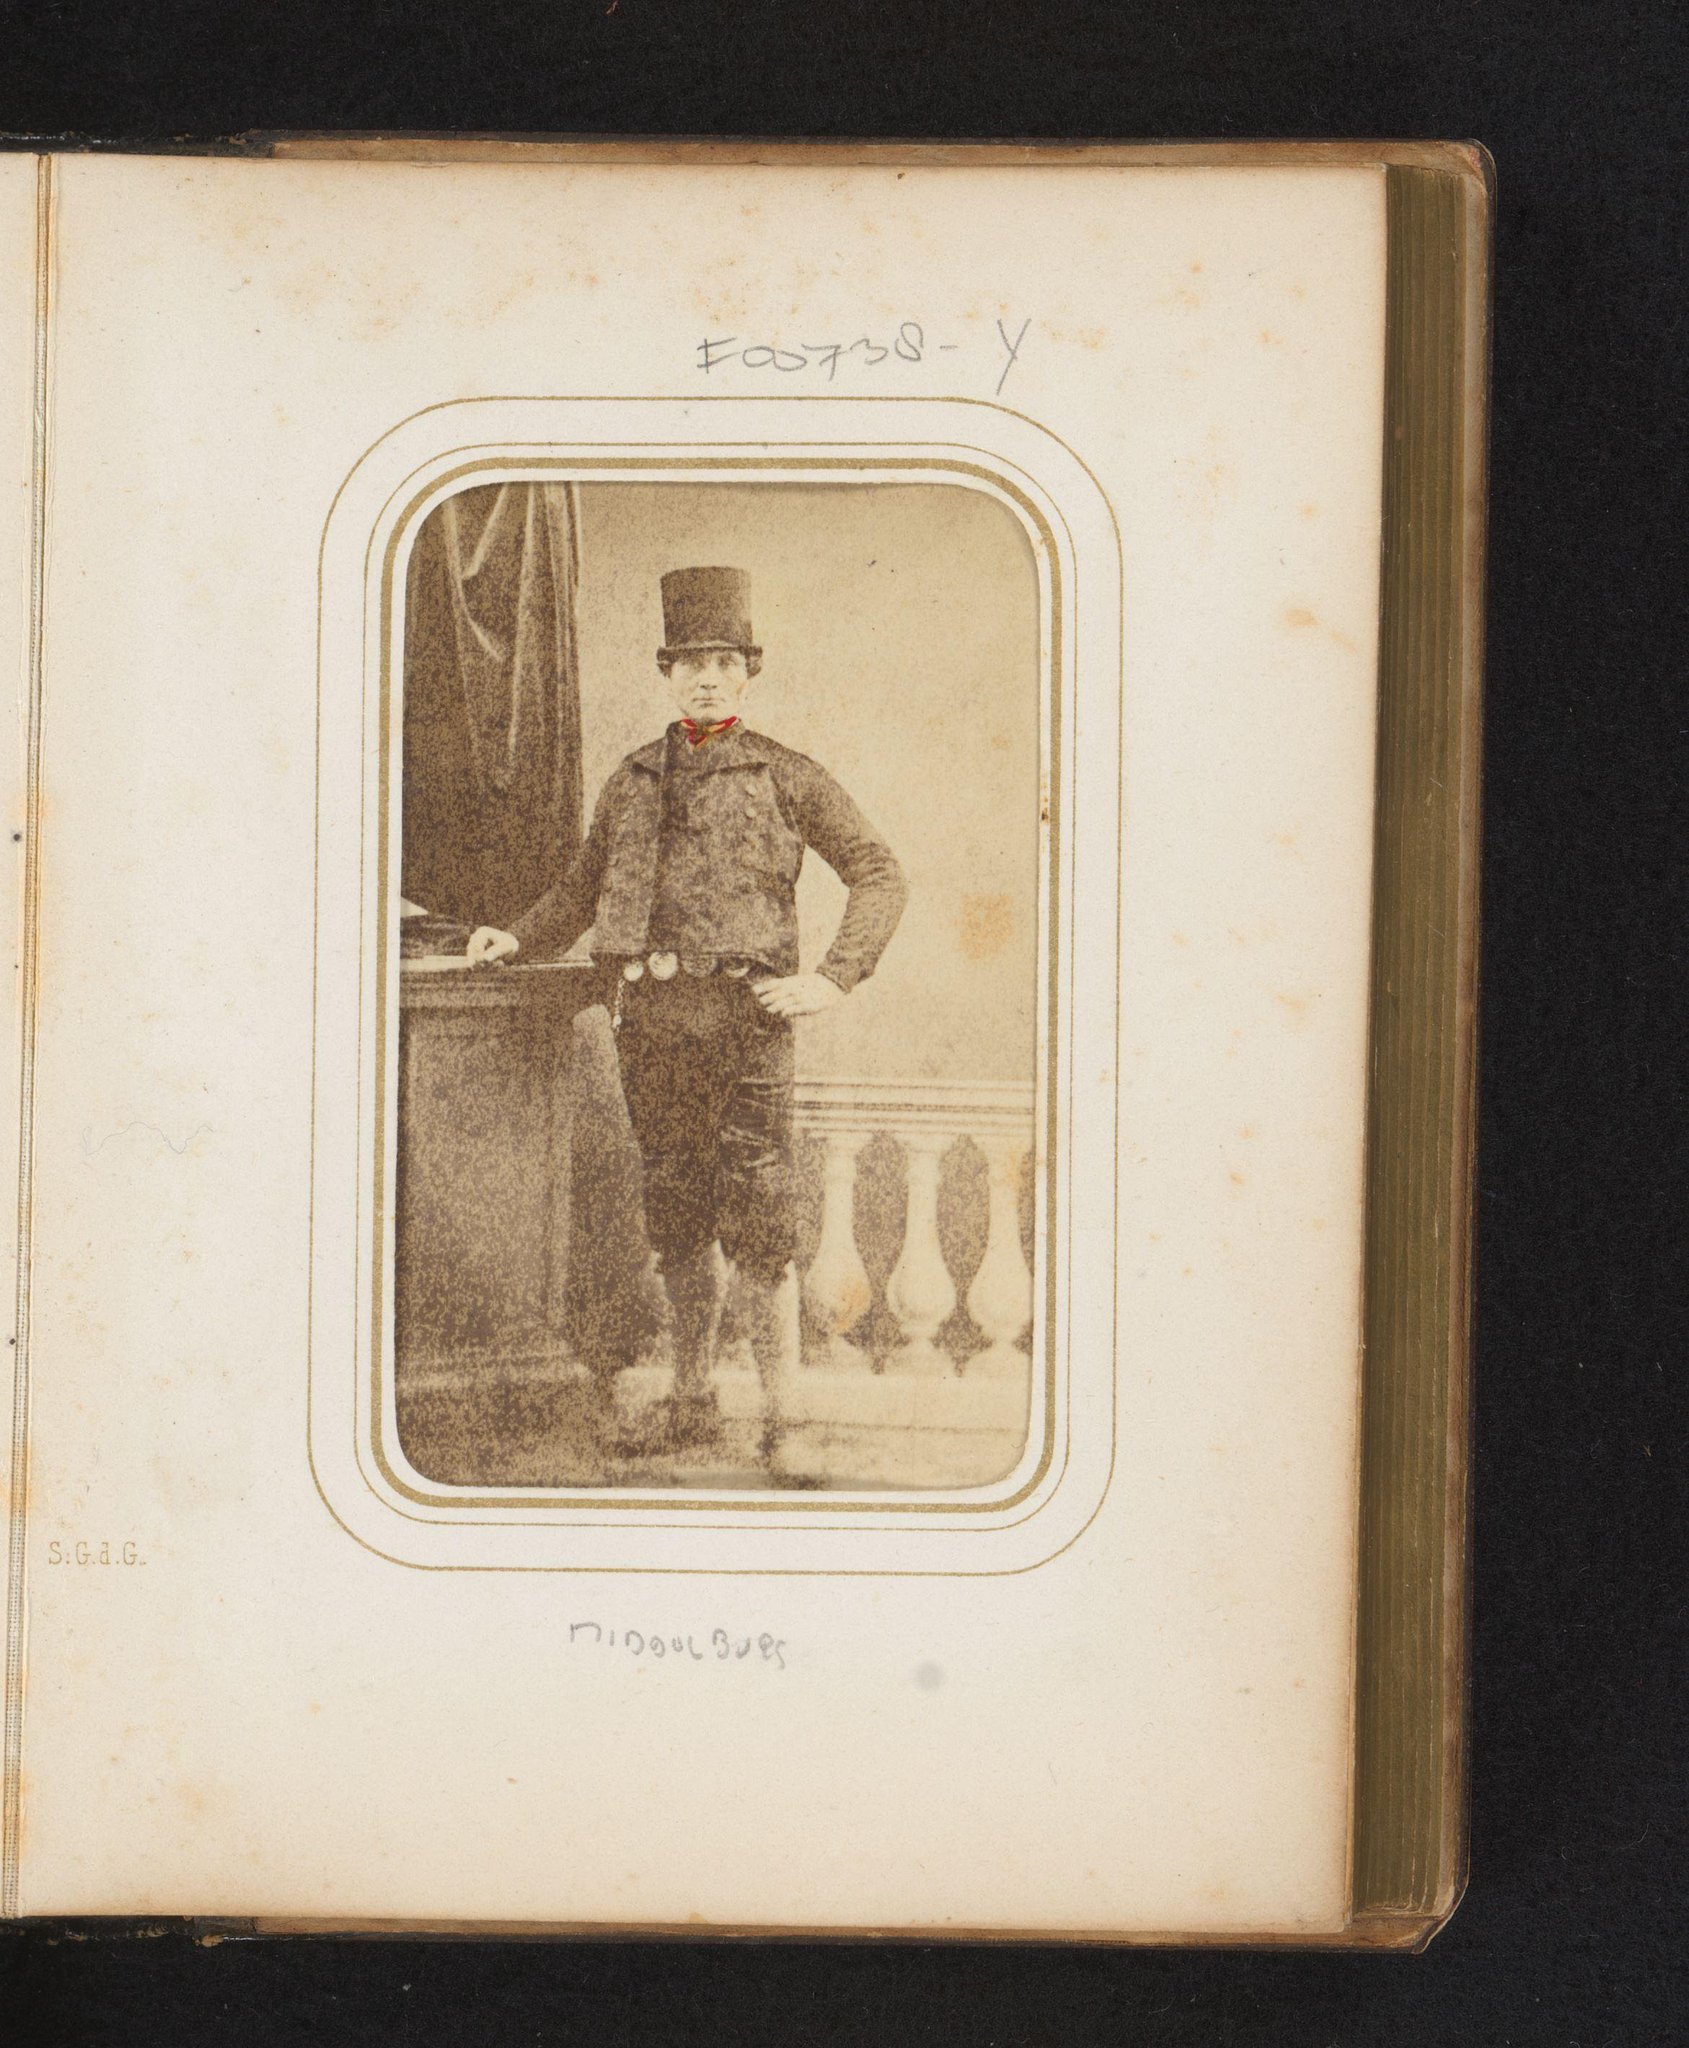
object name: carte de visite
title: La Zélande. Middelbourg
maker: andries jager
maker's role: publisher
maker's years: 1825-1905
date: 1860-1890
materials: cardboard, photographic support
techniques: albumen print, hand coloring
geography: amsterdam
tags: folk costume, regional costume (+ men's clothes), historical persons, netherlands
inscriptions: inscription: ‘Breveté S.G.D.G.’, inscription: ‘Publié par A. Jager, Water 110, Amsterdam./ Le droit de reproduction réservé.’, annotation: ‘Middelburg’